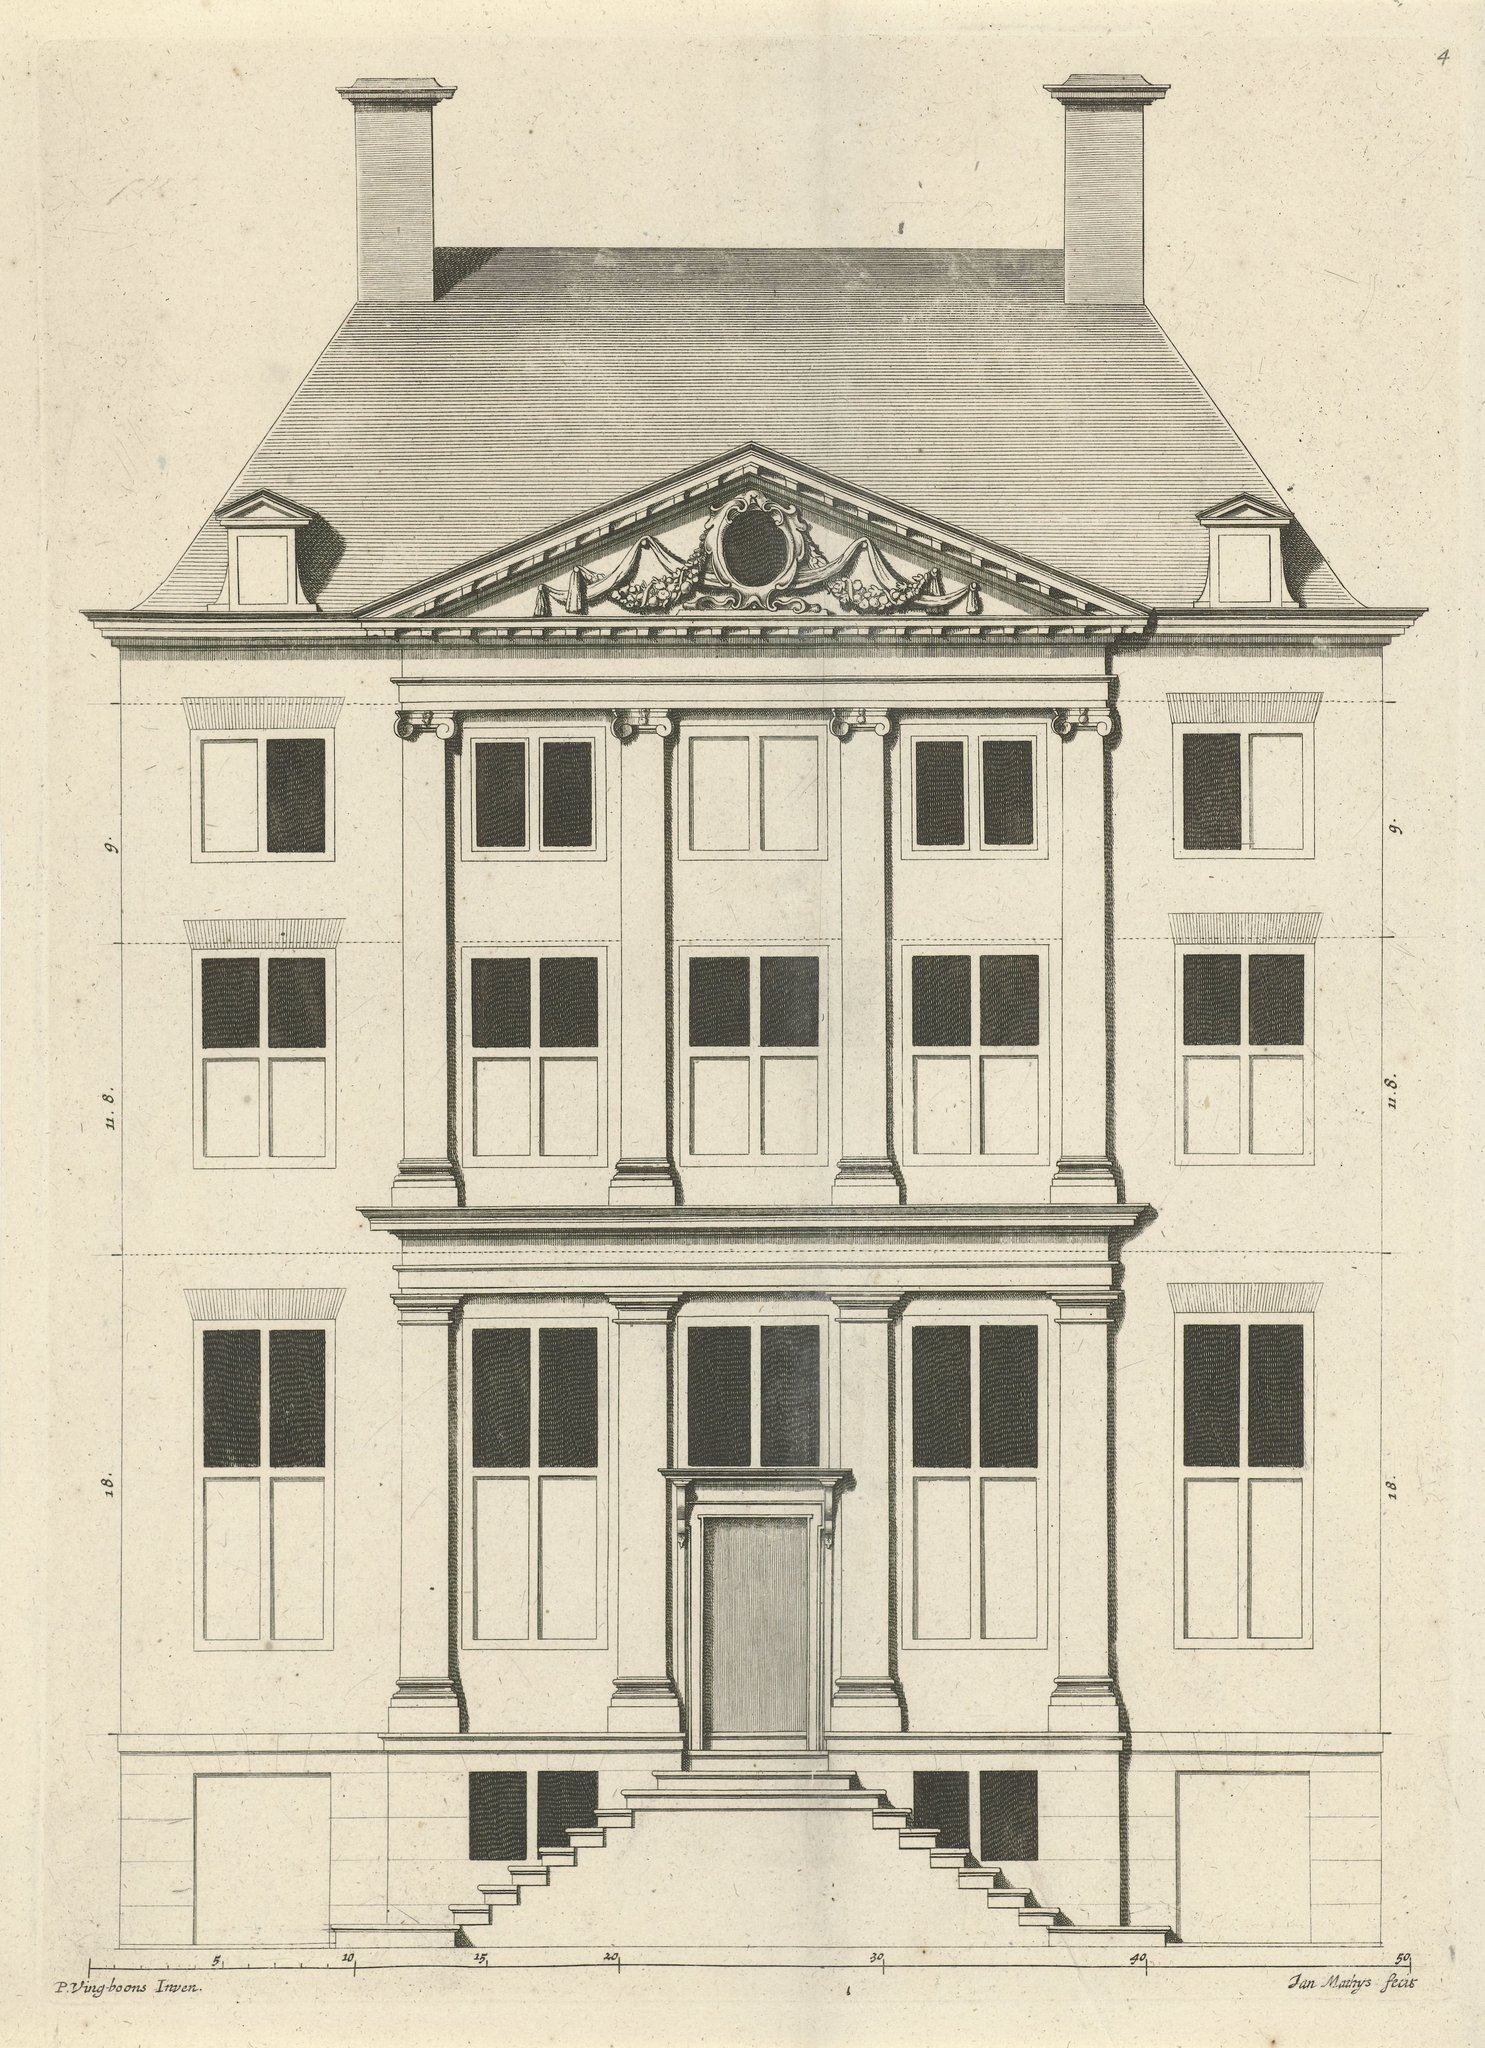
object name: print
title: Voorzijde van een huis aan de Oudezijds Voorburgwal te Amsterdam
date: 1674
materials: paper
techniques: engraving, etching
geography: amsterdam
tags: exterior ~ architectural design or model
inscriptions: collector's mark: Lugt 2228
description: Prent uit: Vingboons, Philips. Tweede deel van de afbeeldsels der voornaemste gebovwen, uyt alle die Philips Vingboons geordineert heeft. Amsterdam: Philips Vingboons en Joan Blaeu, 1674.